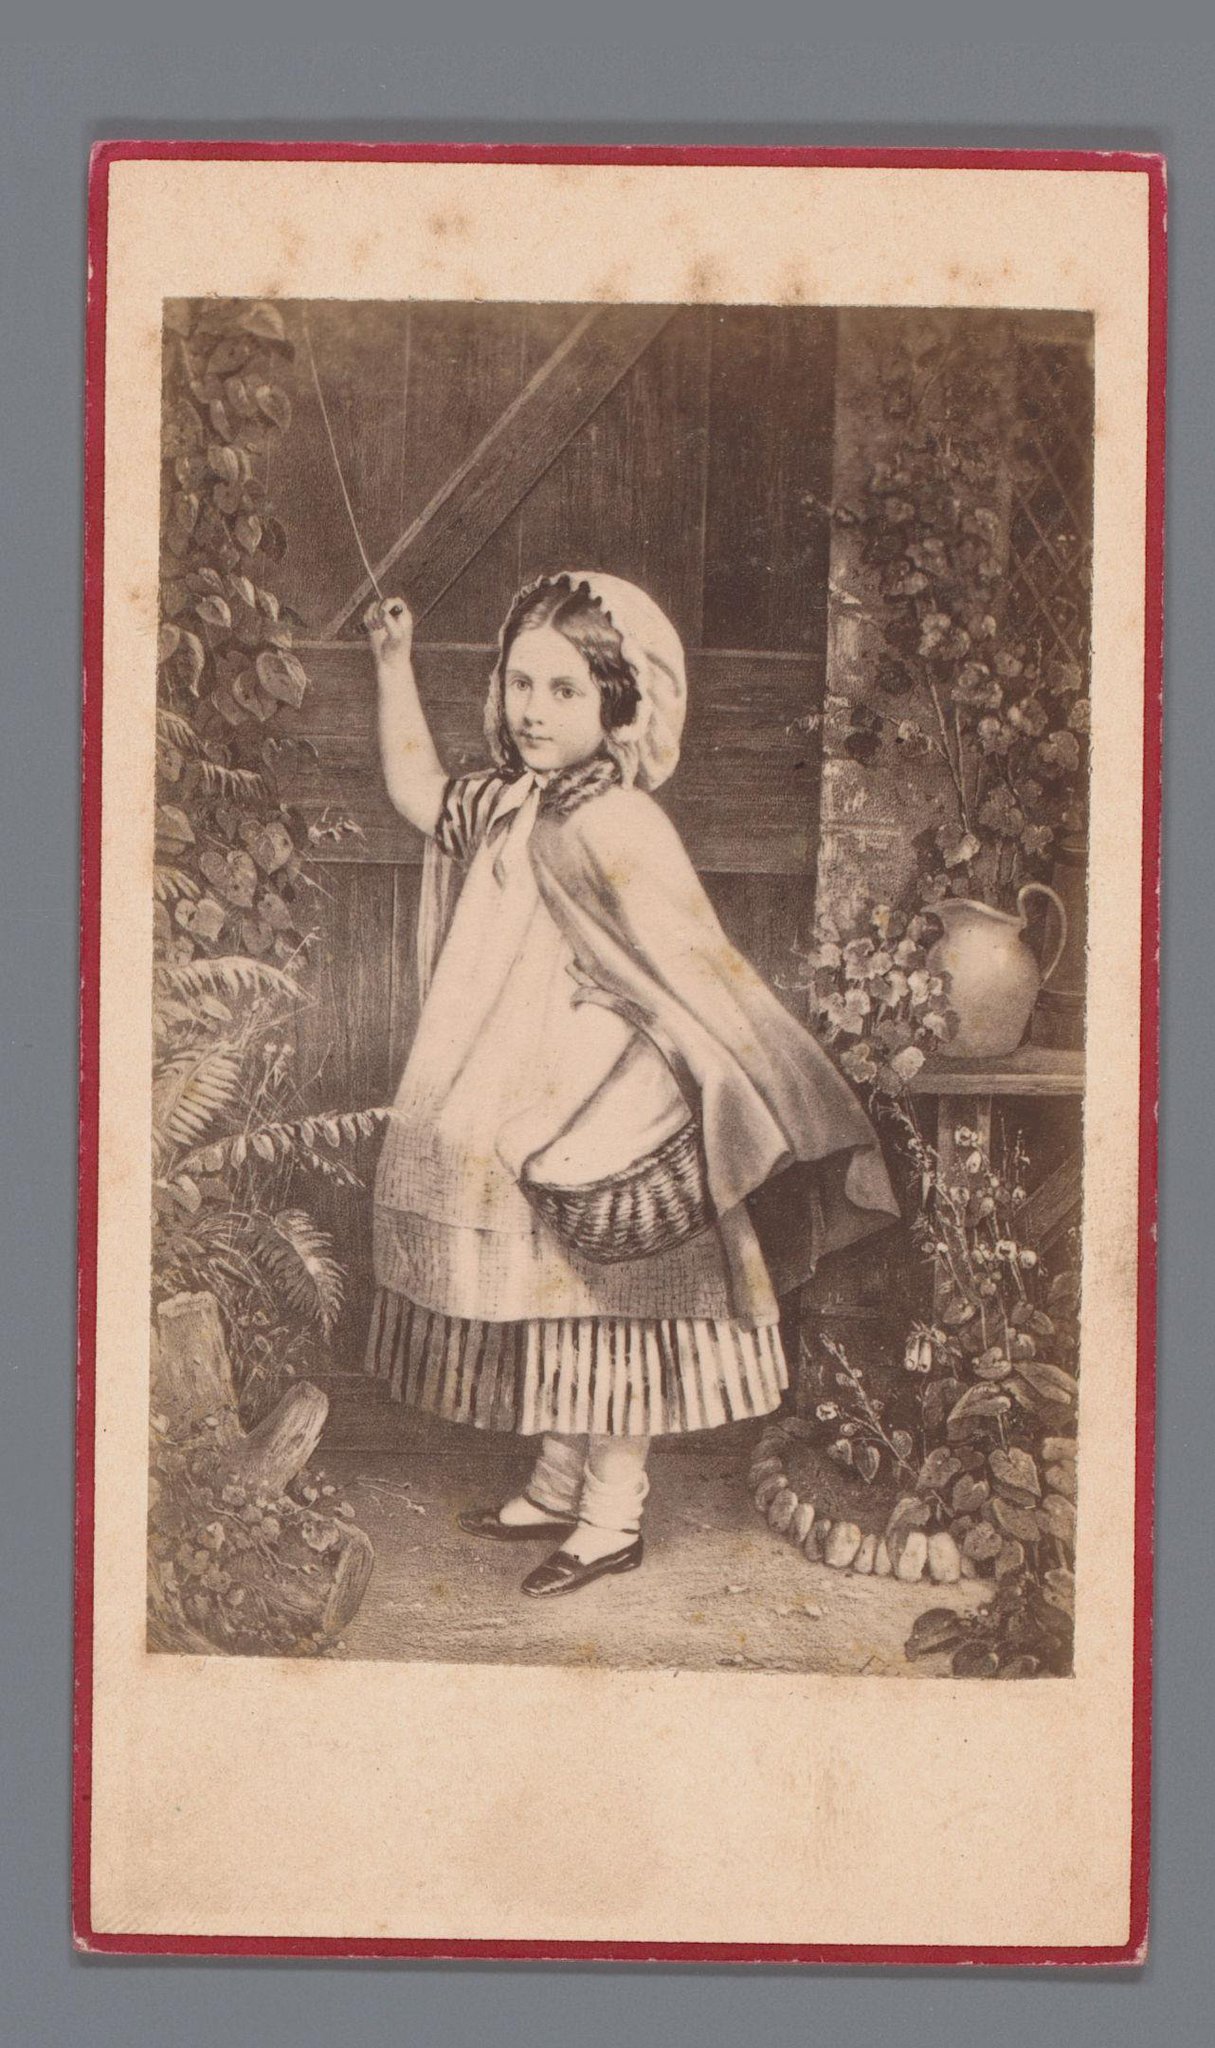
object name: carte de visite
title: Little red Ridinghood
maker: Anonymous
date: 1855-1885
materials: cardboard, paper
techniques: albumen print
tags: tales and fairy tales: little red riding-hood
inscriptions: number: ‘178’